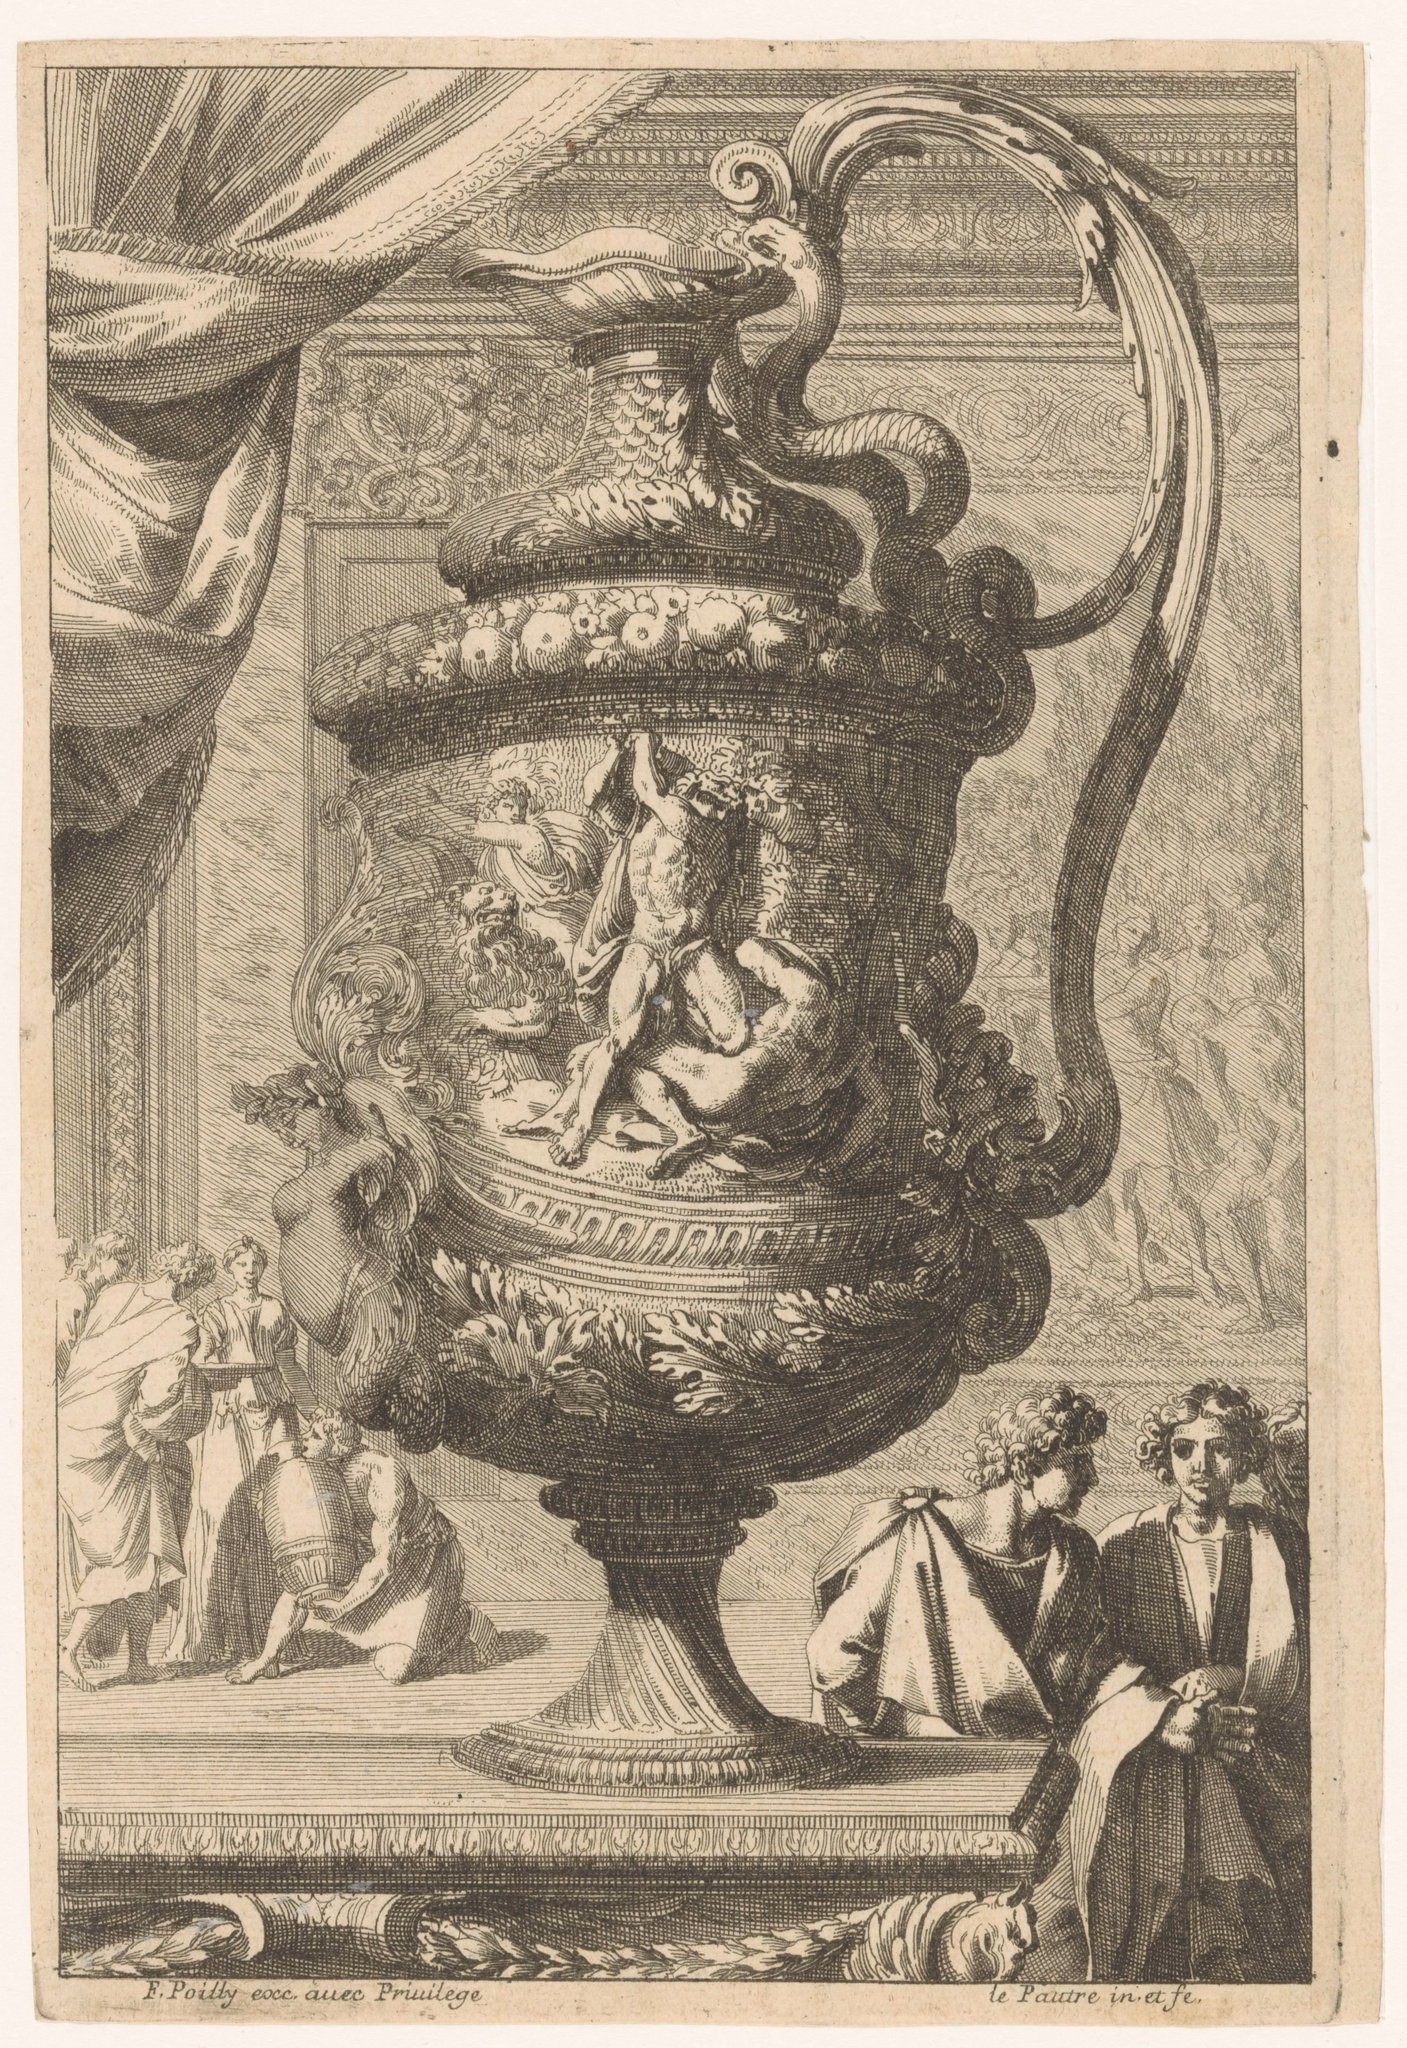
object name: ornament print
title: Schenkkan met Hercules en Caccus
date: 1669-1693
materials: paper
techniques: etching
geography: paris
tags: jar, jug (used as drinking-vessel)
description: Kan met scène van Hercules en Caccus op het lichaam. Een slang ondersteunt het handvat.